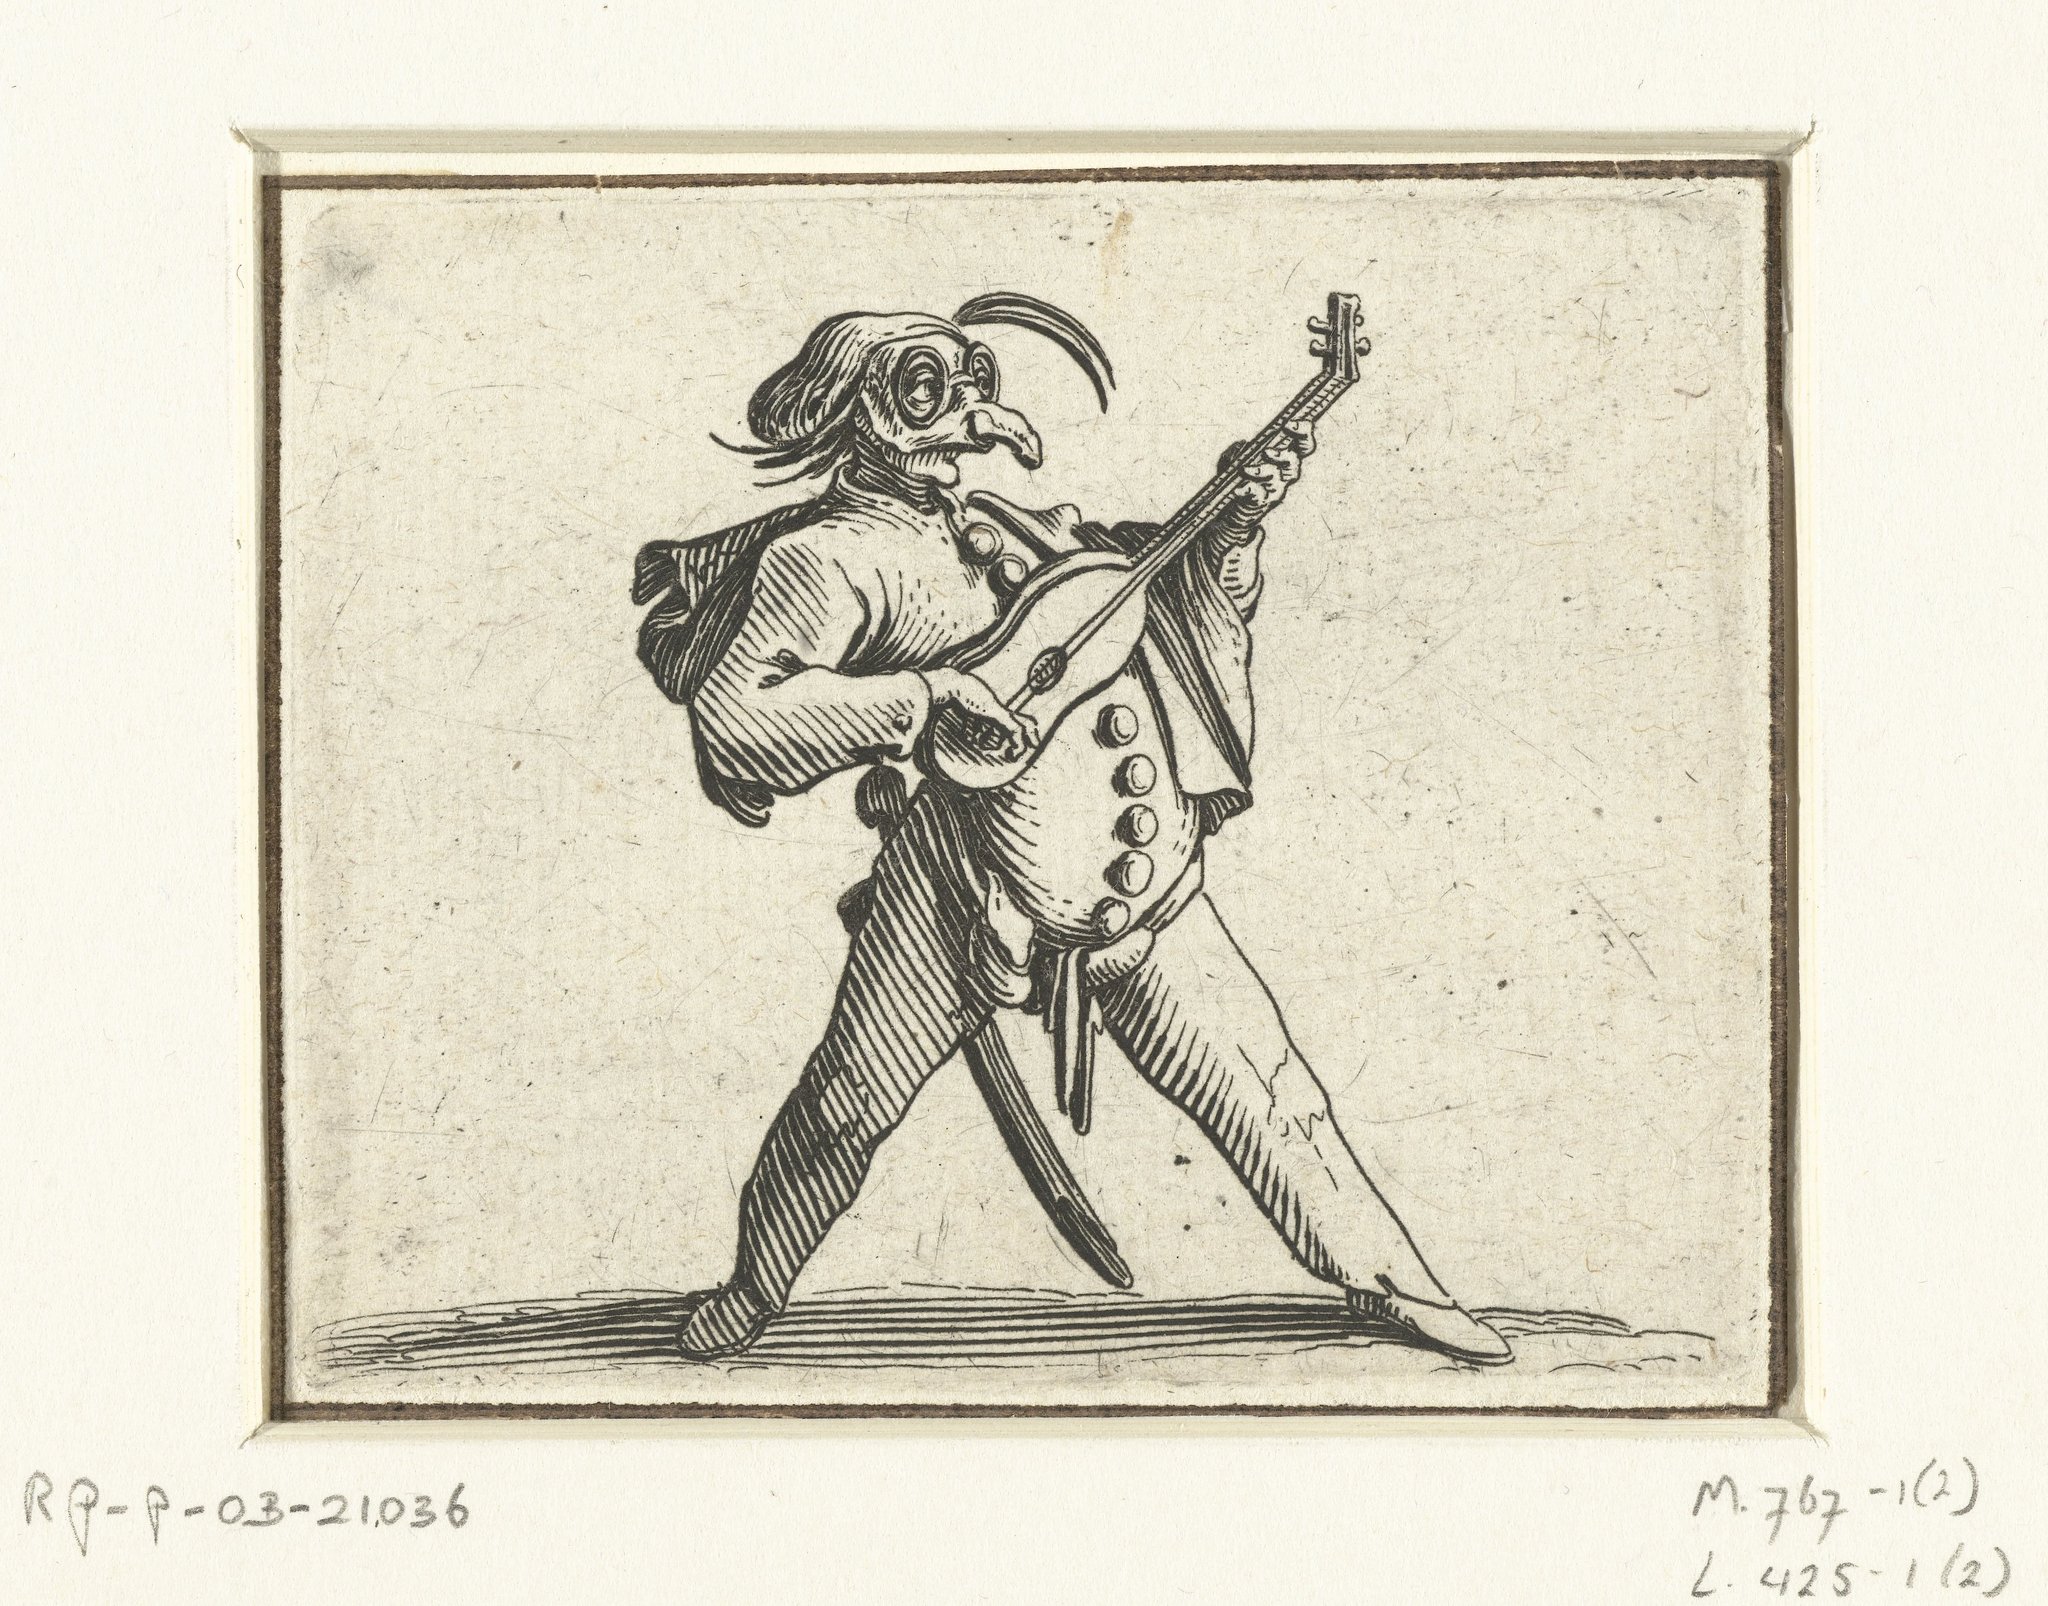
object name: print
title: Diverse groteske figuren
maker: jacques callot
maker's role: draughtsman, print maker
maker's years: 1592-1635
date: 1621-1625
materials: paper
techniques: engraving, etching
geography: nancy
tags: mask, types in 'commedia dell'arte', hacking and thrusting weapons: sword, one person playing string instrument (plucked), cithern, mandolin, guitar, balalaika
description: Commedia dell'arte-figuur, van voren gezien, een gitaar bespelend, een muts met twee veren op het hoofd, een masker voor het gezicht, een zwaard aan zijn rechterzijde. Deze prent is onderdeel van een serie van 21 prenten met groteske figuren; vrijwel al die figuren zijn karikaturen van kleine mensen, velen zijn gebocheld.